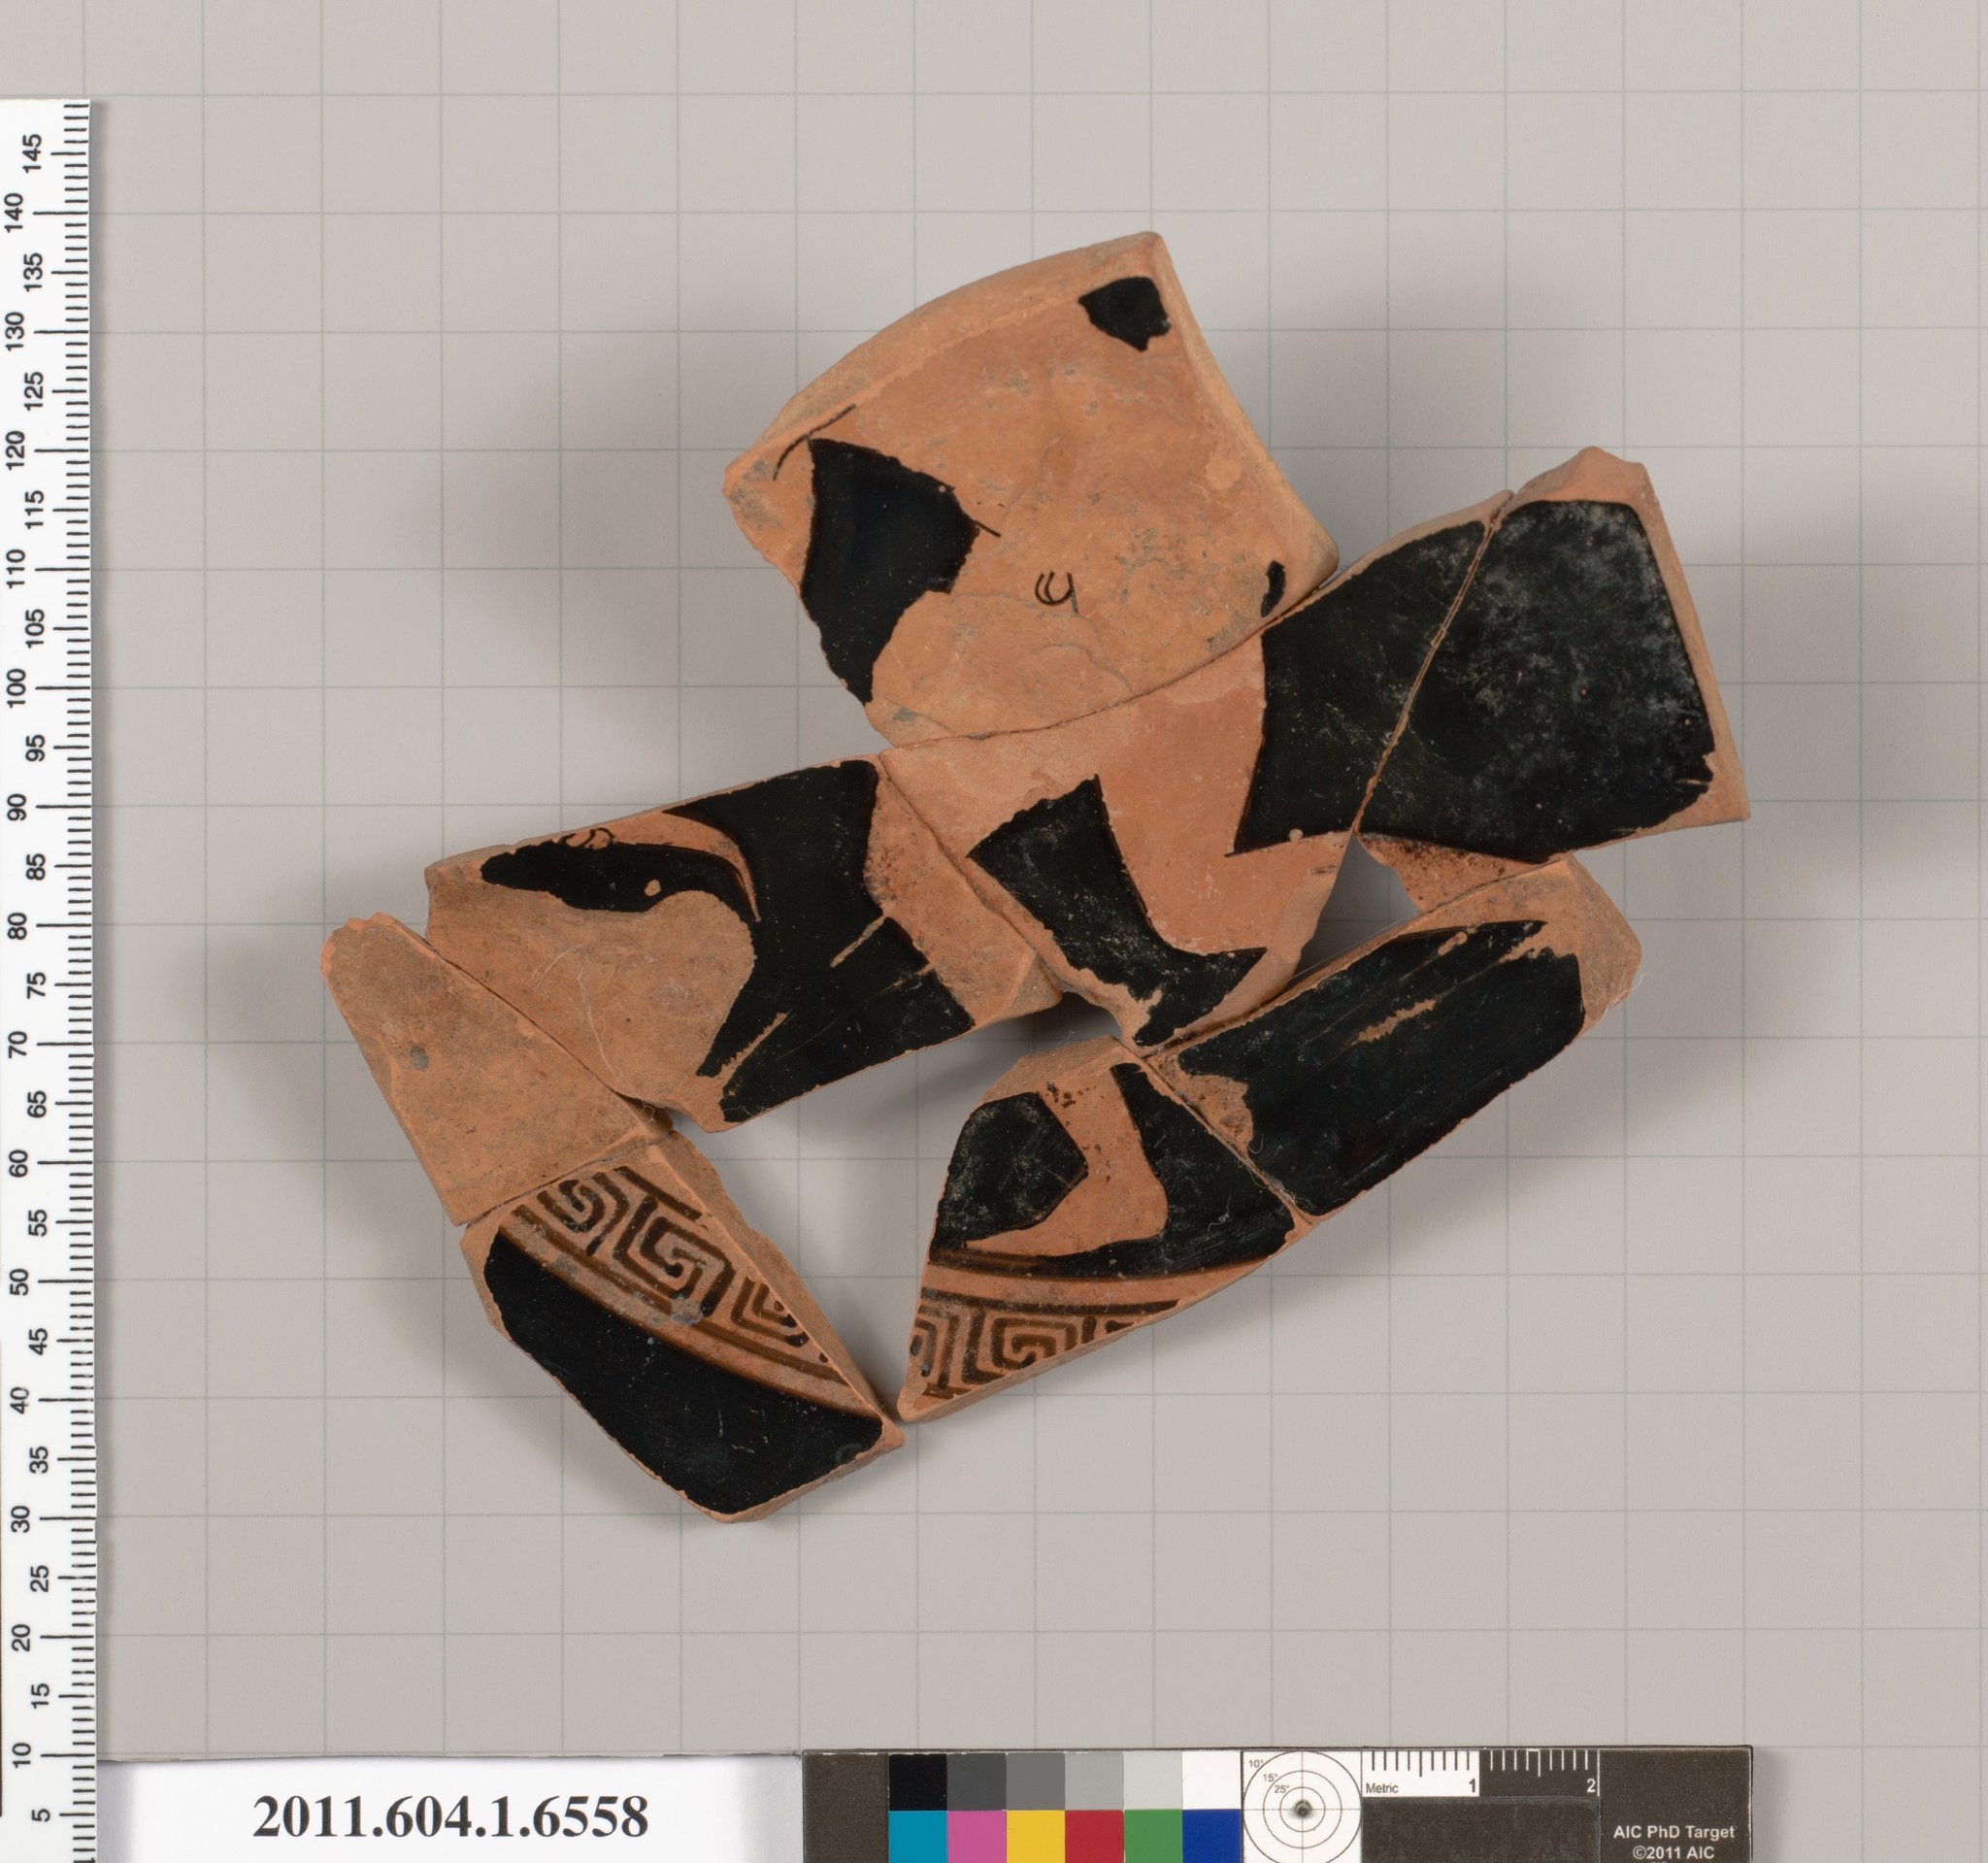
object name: kylix fragment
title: Terracotta fragment of a kylix (drinking cup)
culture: greek, attic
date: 490-480 BCE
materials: terracotta